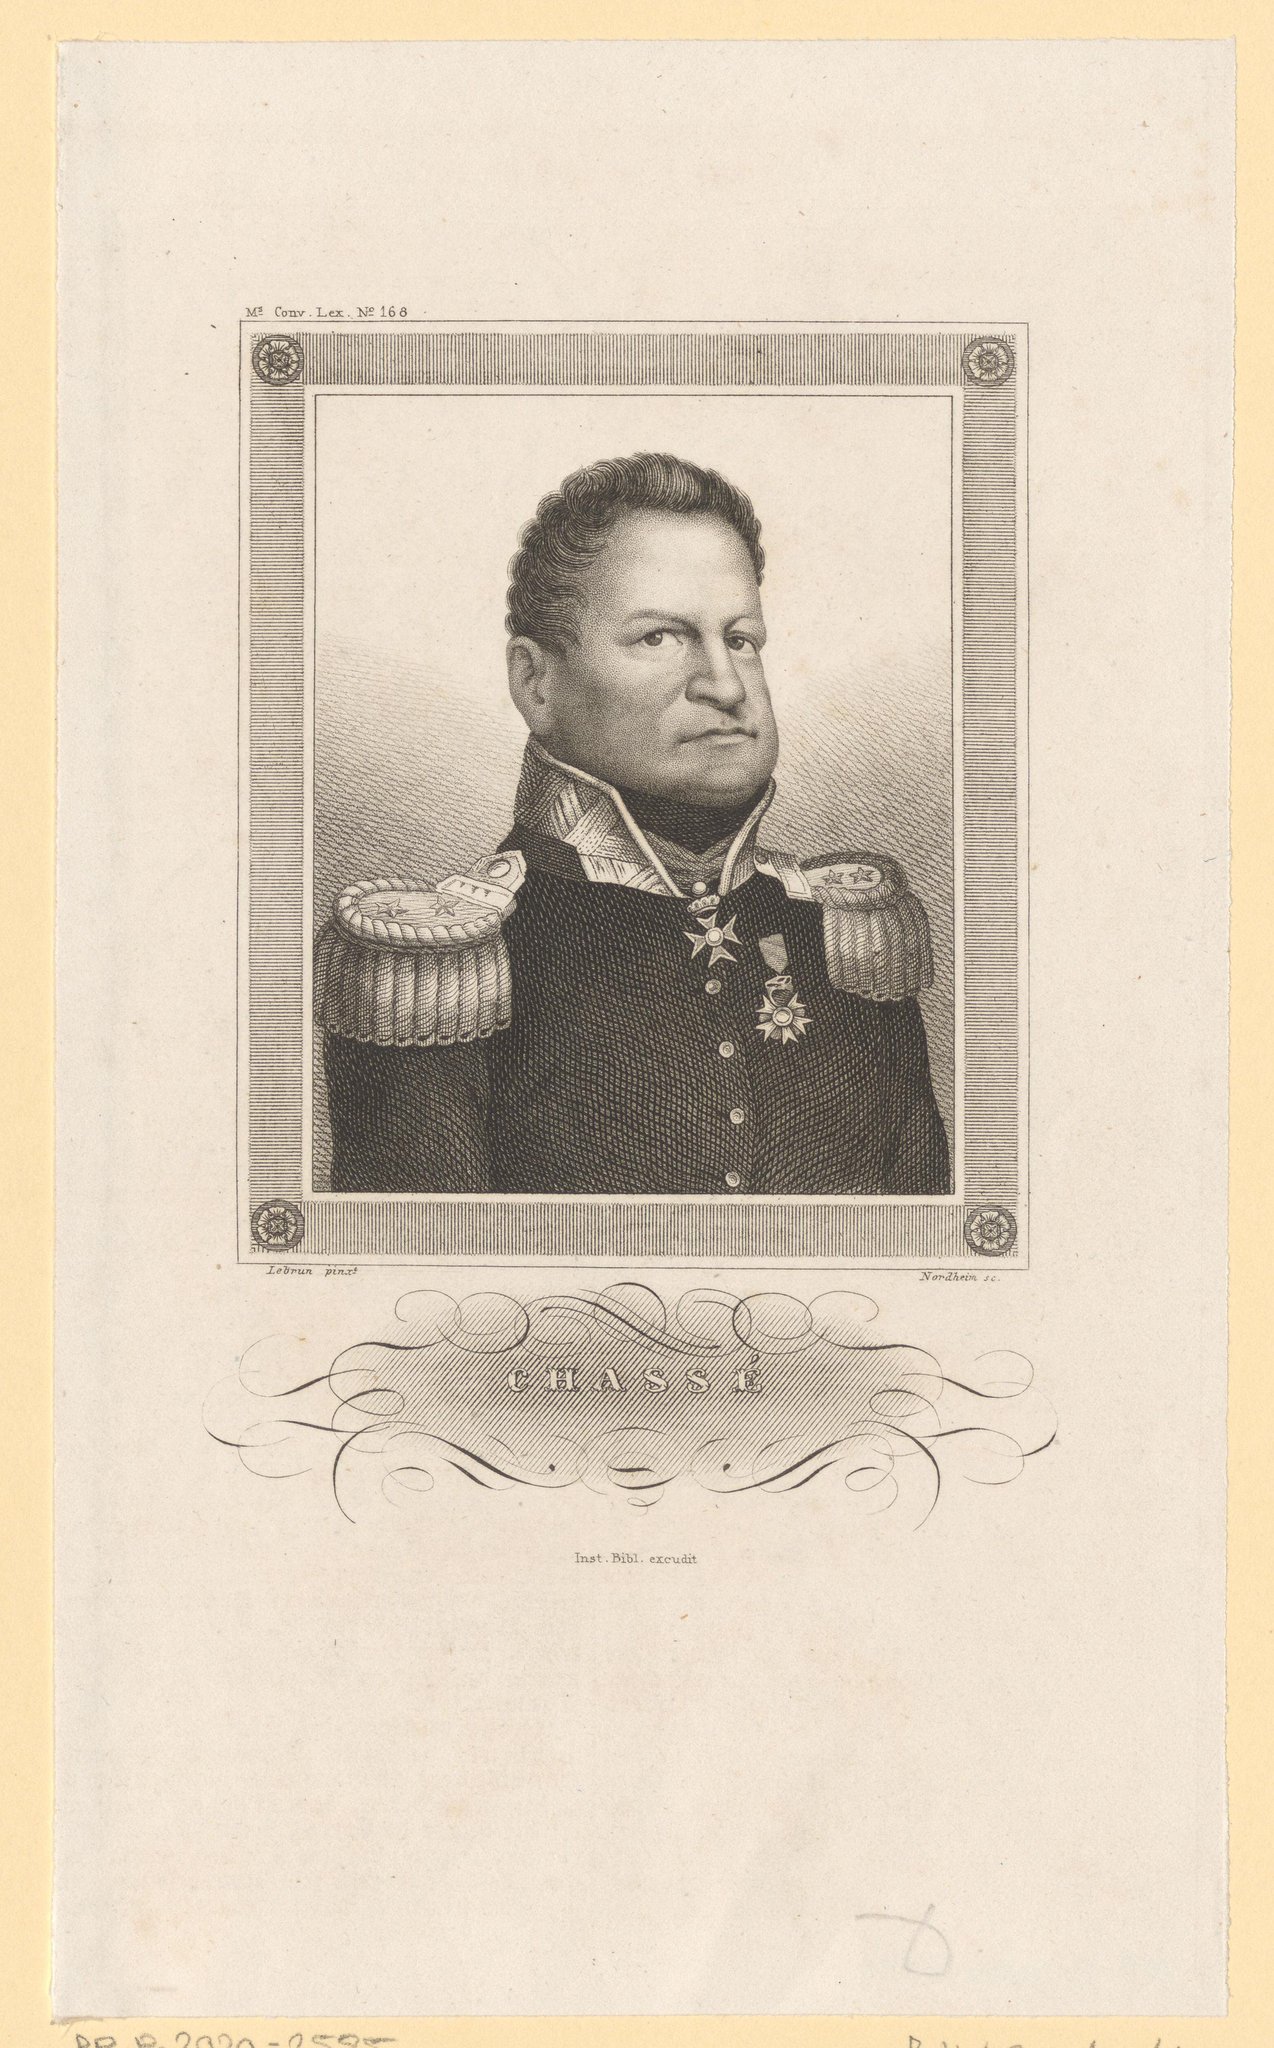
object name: print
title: Portret van David Hendrik baron Chassé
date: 1828-1874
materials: paper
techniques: engraving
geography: hildburghausen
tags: david hendrik baron chassé, commander-in-chief, general, marshal, historical persons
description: Linksboven genummerd: Ms. Conv. Lex. No 169.